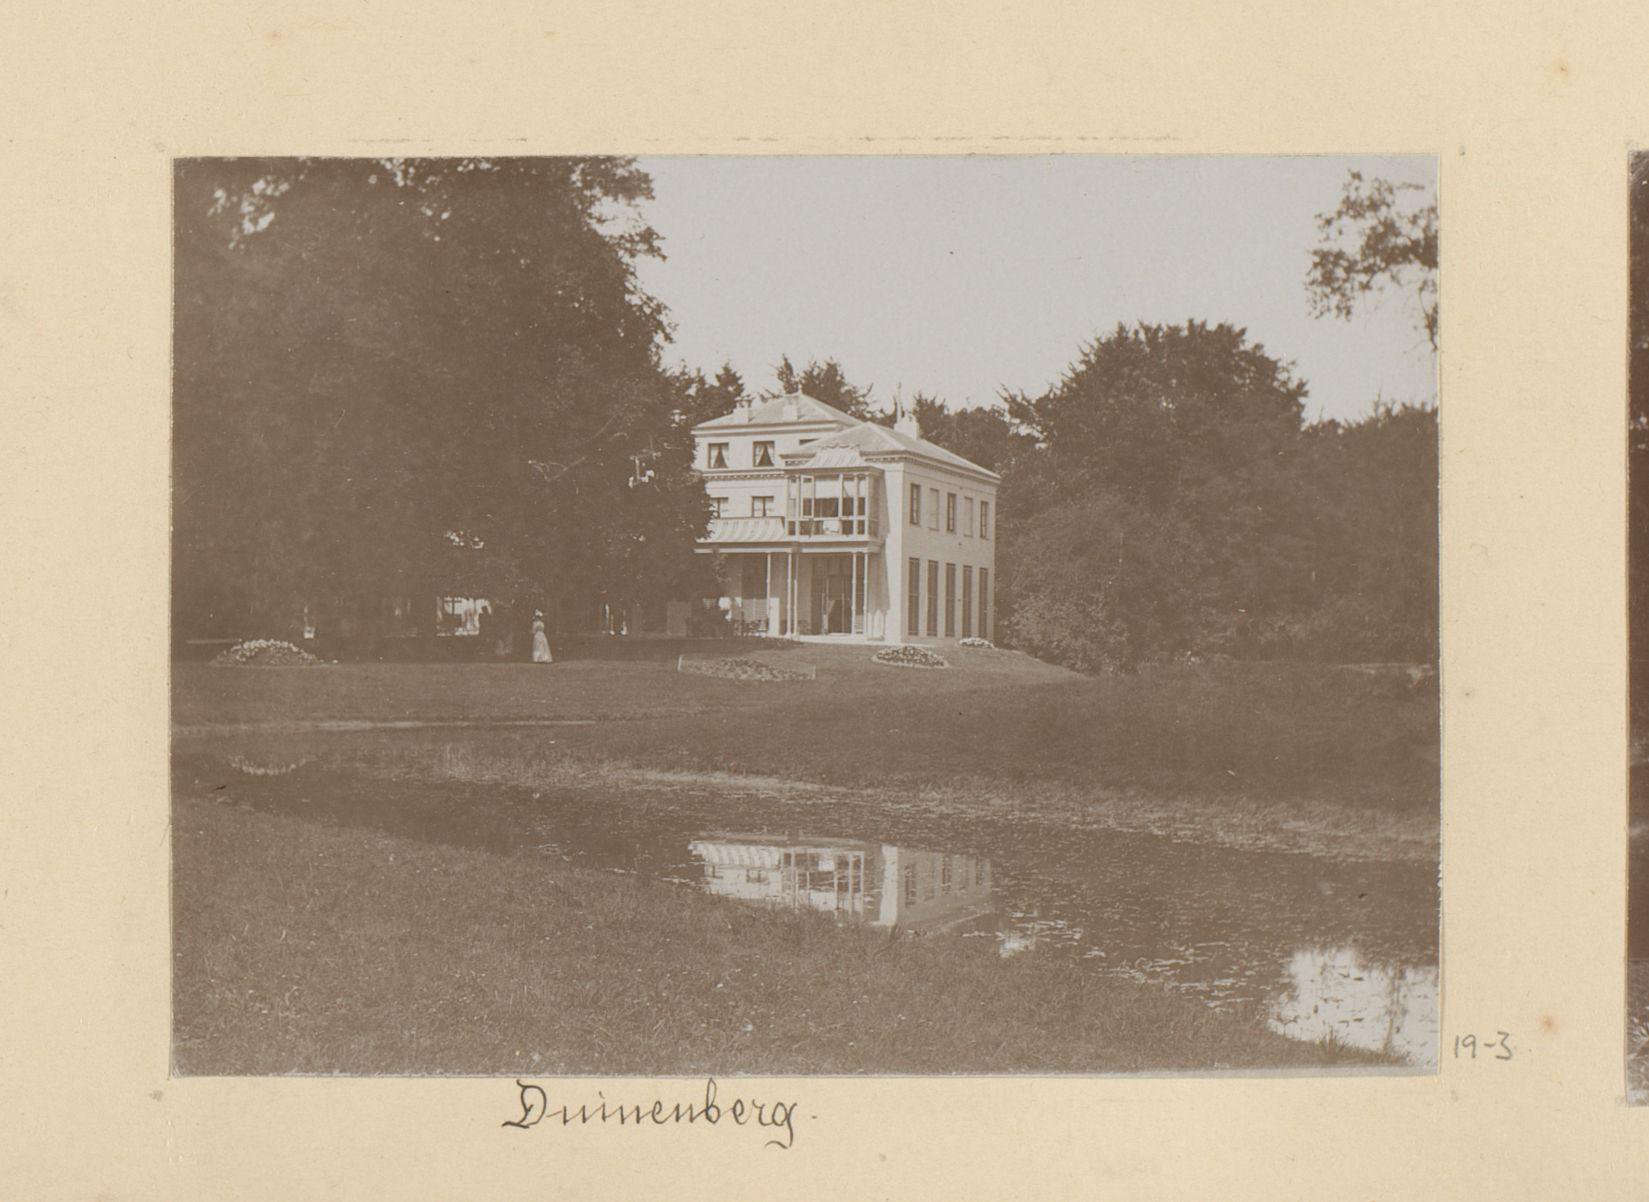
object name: photograph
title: Gezicht op de voormalige buitenplaats Duinenberg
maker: hendrik herman van den berg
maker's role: amateurfotograaf, jurist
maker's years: 1875-1944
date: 1890-1894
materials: paper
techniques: collodion silver print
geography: velsen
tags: rural housing, e.g. country-house, villa, cottage, forest, wood, pond, pool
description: Foto 3 op albumblad 19 uit album "Amsterdam 1890-1894".